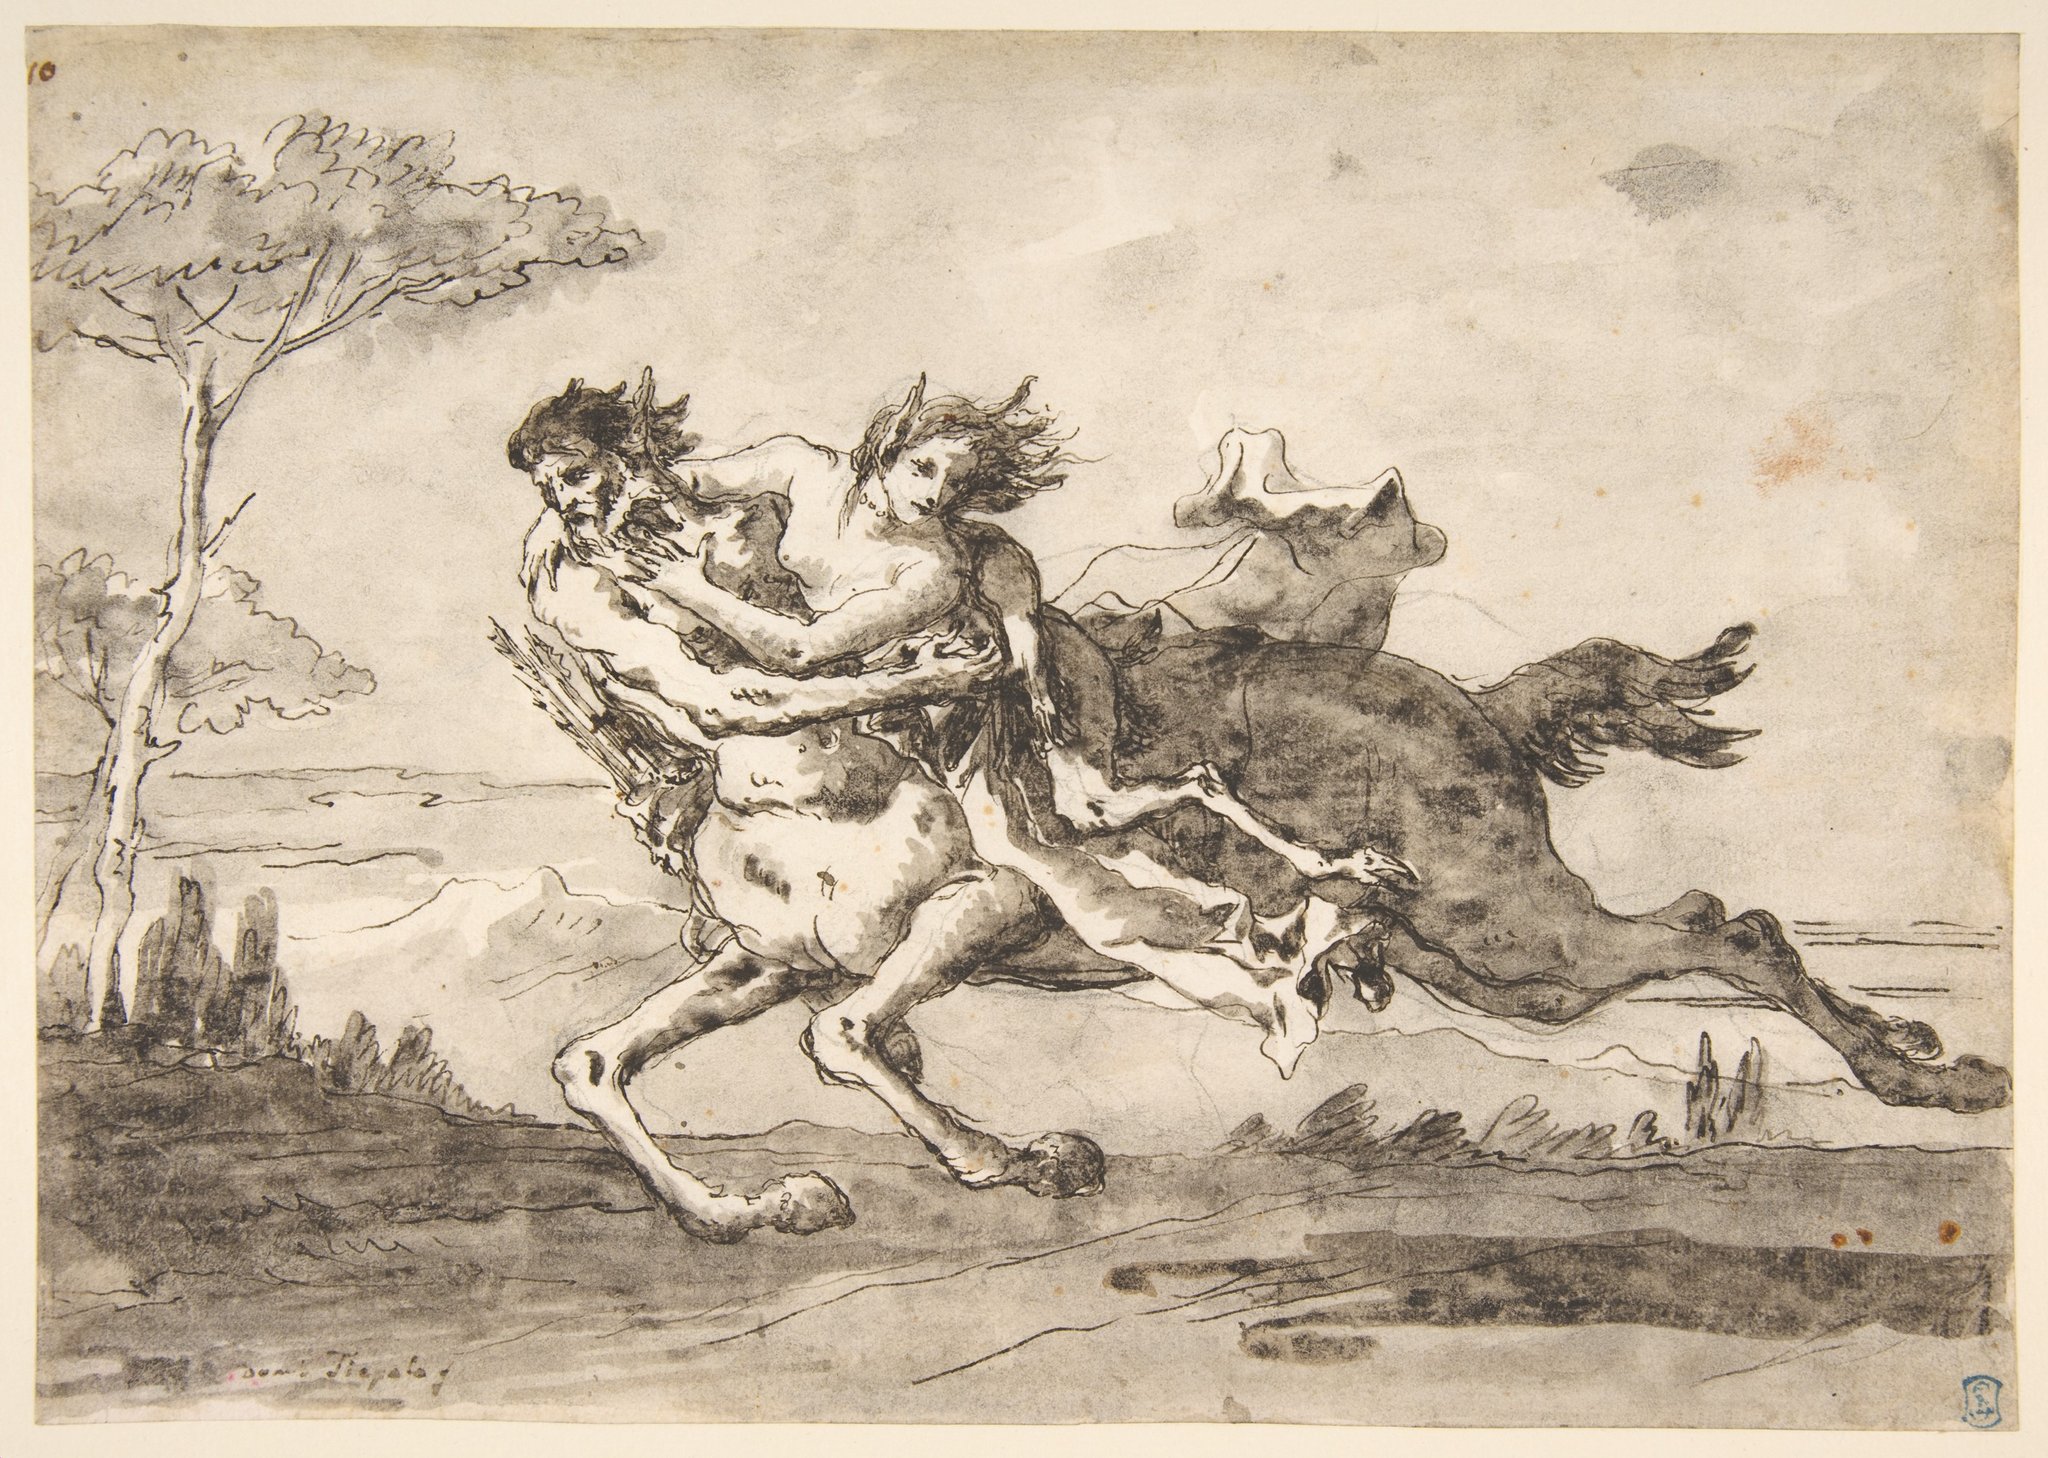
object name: drawing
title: Centaur Abducting a Satyress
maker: giovanni domenico tiepolo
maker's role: artist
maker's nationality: italian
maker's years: 1727-1804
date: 1727-1804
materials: chalk, ink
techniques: brush, pen, wash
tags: centaurs,satyrs,trees